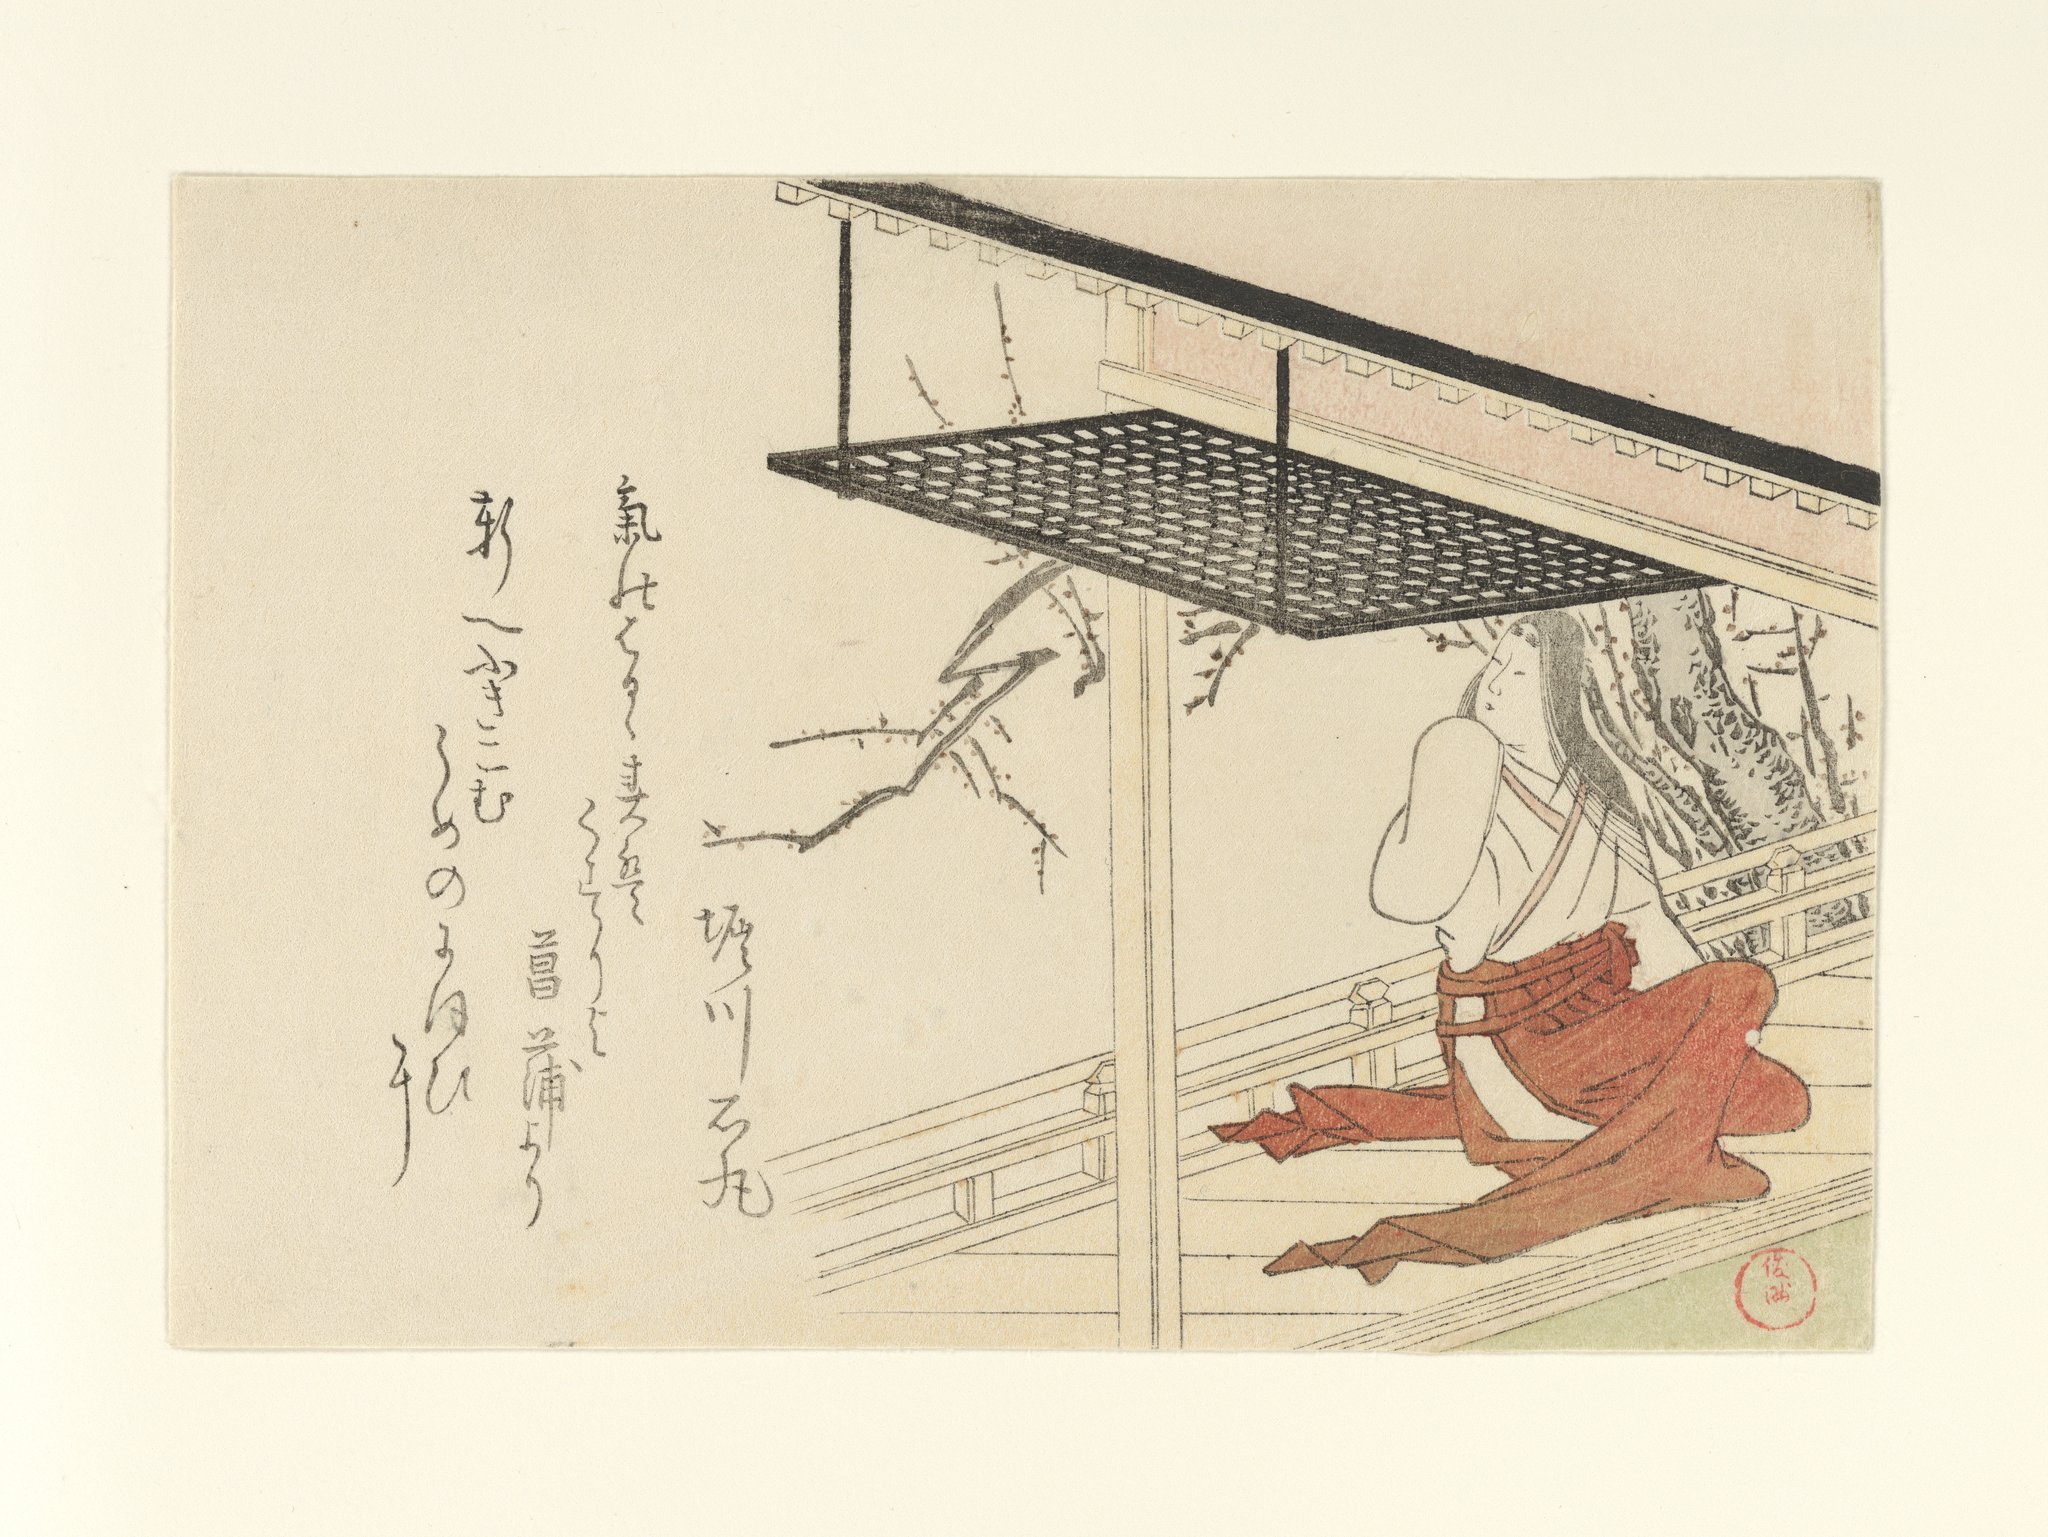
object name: print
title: Court Lady on Veranda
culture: japanese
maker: kubo shunman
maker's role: artist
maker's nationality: japanese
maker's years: 1757-1820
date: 1796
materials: ink, paper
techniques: surimono, woodblock print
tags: women